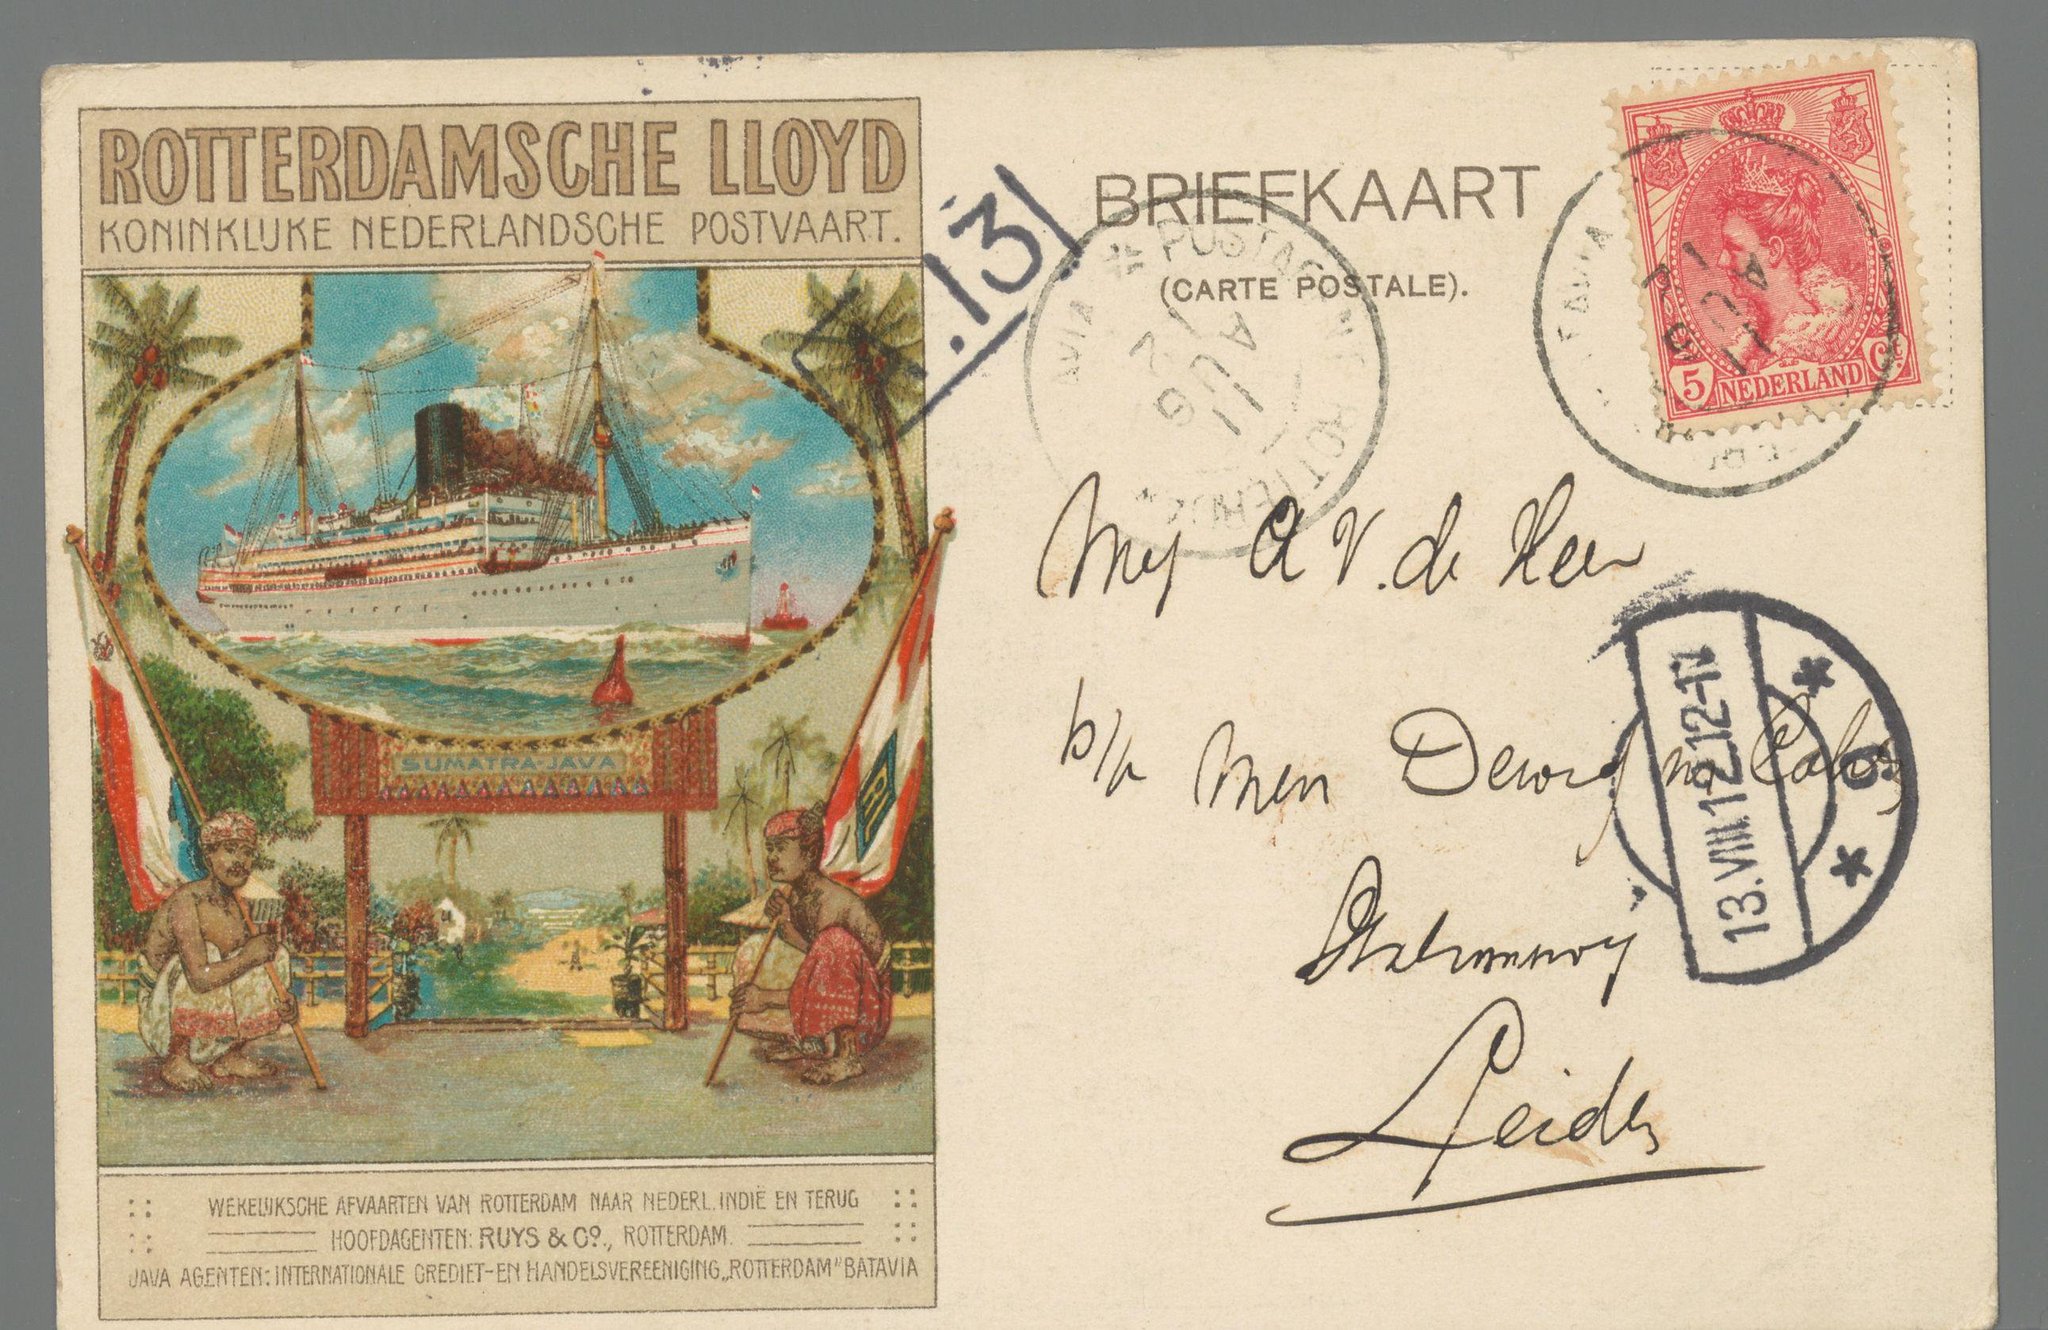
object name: ansichtkaart, prentbriefkaart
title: Rotterdamsche Lloyd. Koninklijke Nederlandsche Postvaart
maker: Anonymous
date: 1892-1912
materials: cardboard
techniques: lithograph, writing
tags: steamship, motorship, flag, colours (as symbol of the state, etc.), netherlands, indonesia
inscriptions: postage stamp